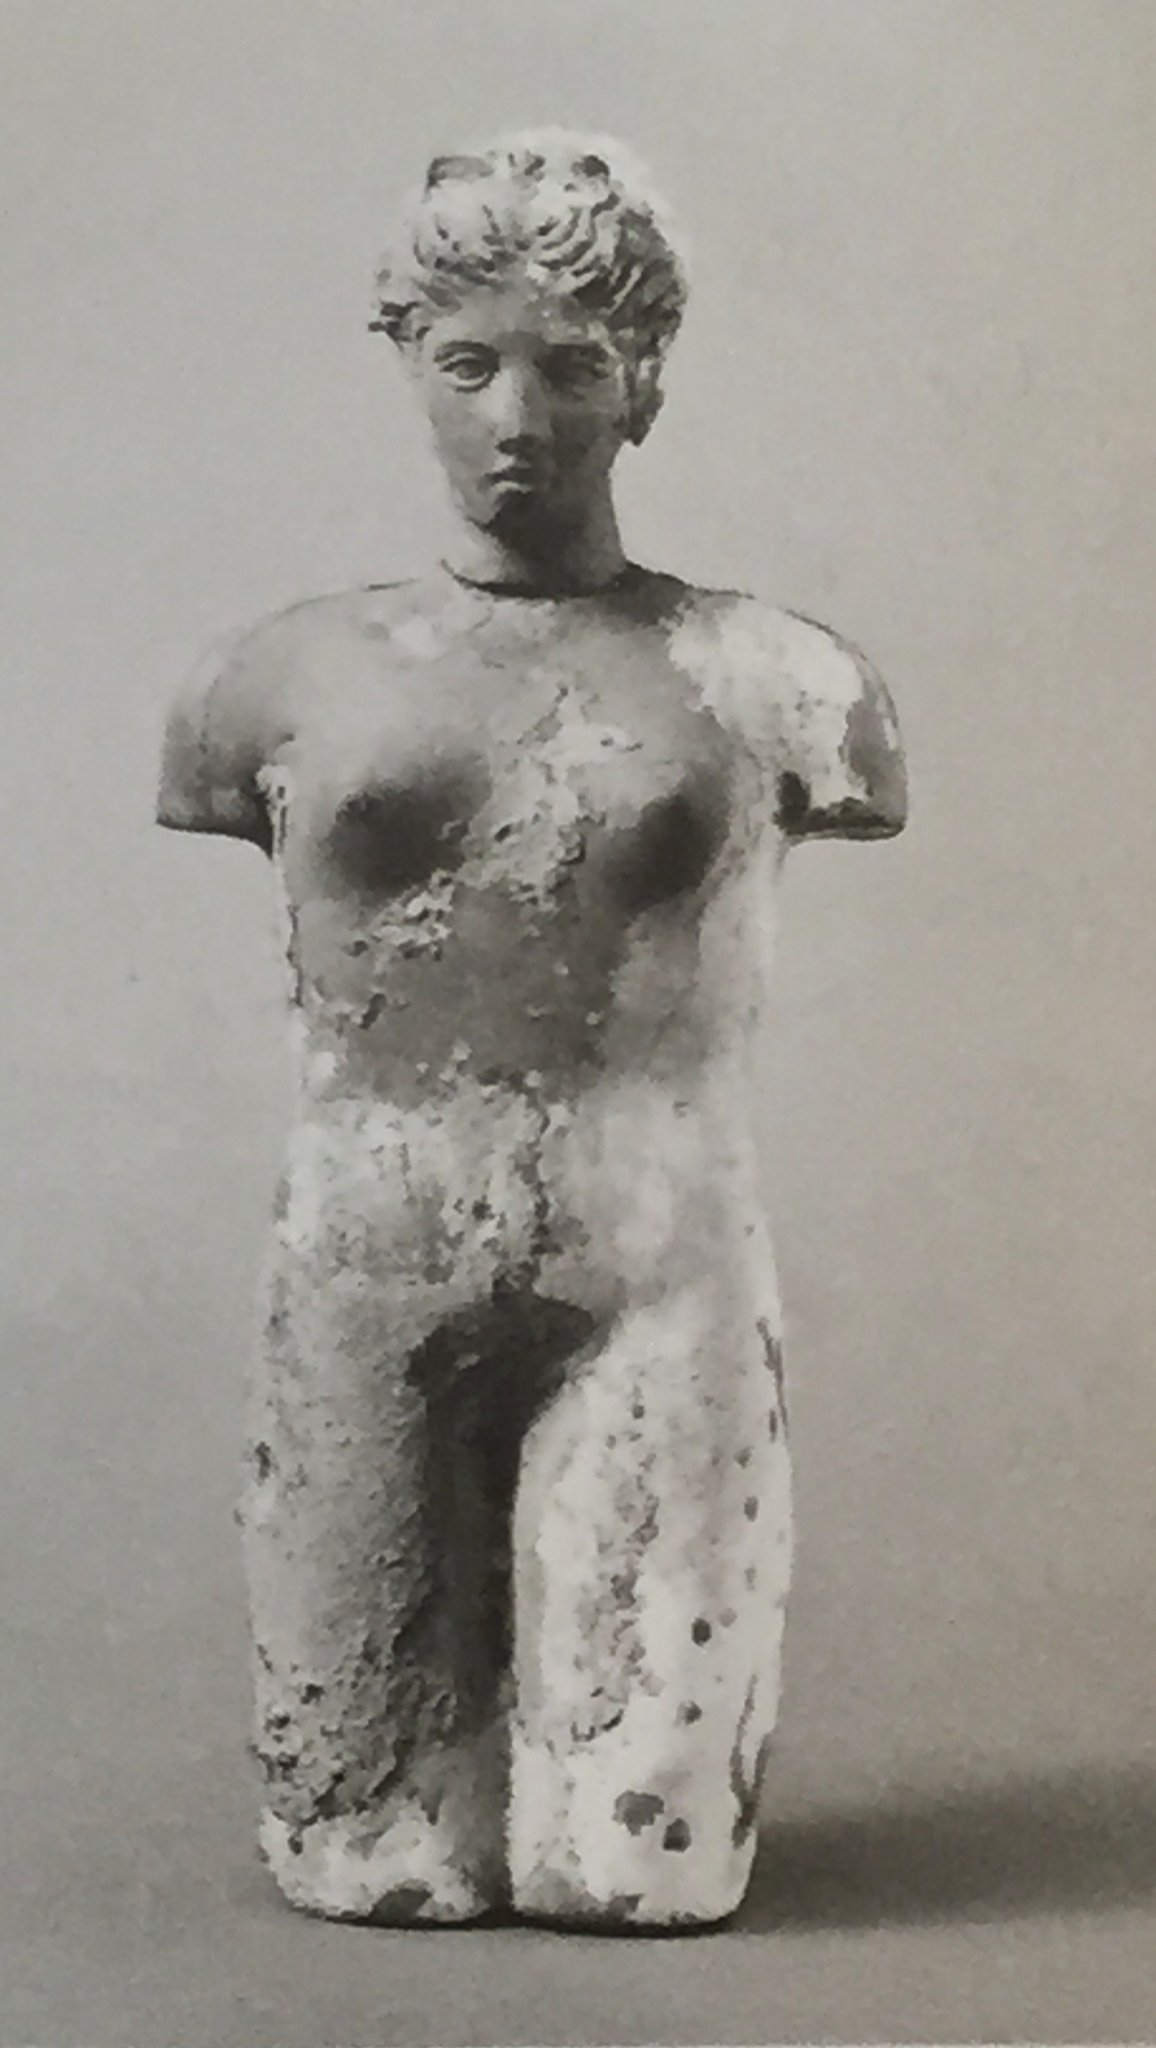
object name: limbless doll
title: Terracotta limbless "doll"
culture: greek, attic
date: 434-368 BCE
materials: terracotta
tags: women